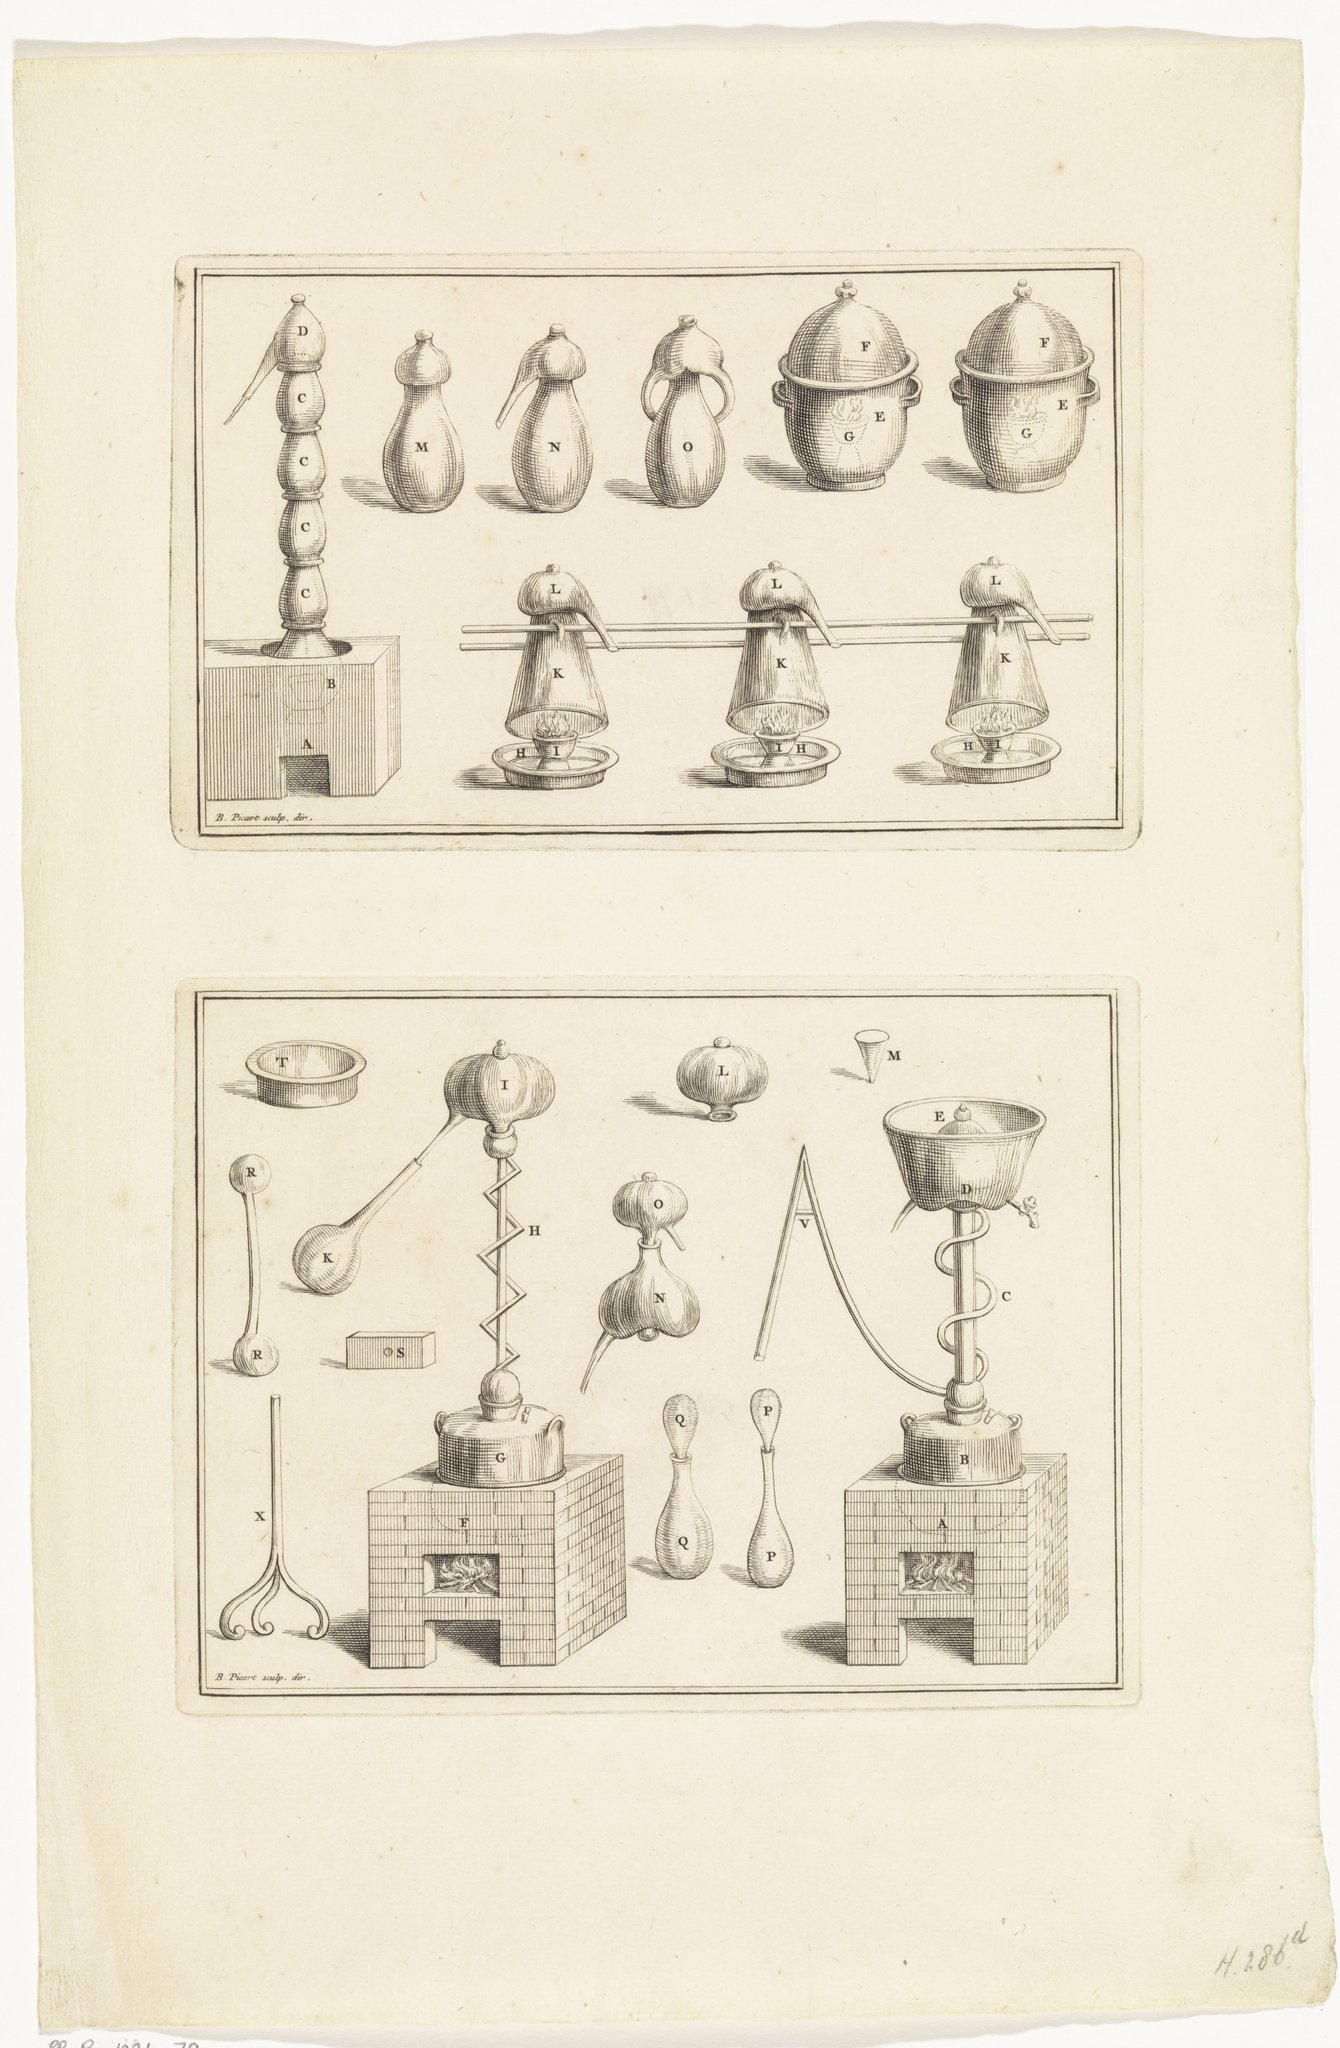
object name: book illustration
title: Destilleerapparatuur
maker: bernard picart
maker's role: draughtsman, print maker, publisher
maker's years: 1673-1733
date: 1683-1733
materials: paper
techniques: etching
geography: amsterdam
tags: tools, aids, implements ~ crafts and industries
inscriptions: collector's mark: Lugt 2233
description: Prenten bedoeld voor: Chomel, Noel. Dictionnaire oeconomique, contenant divers moïens d'augmenter son bien, et de conserver sa santé. Amsterdam: Johannes Covens en Cornelis Mortier, 1732.